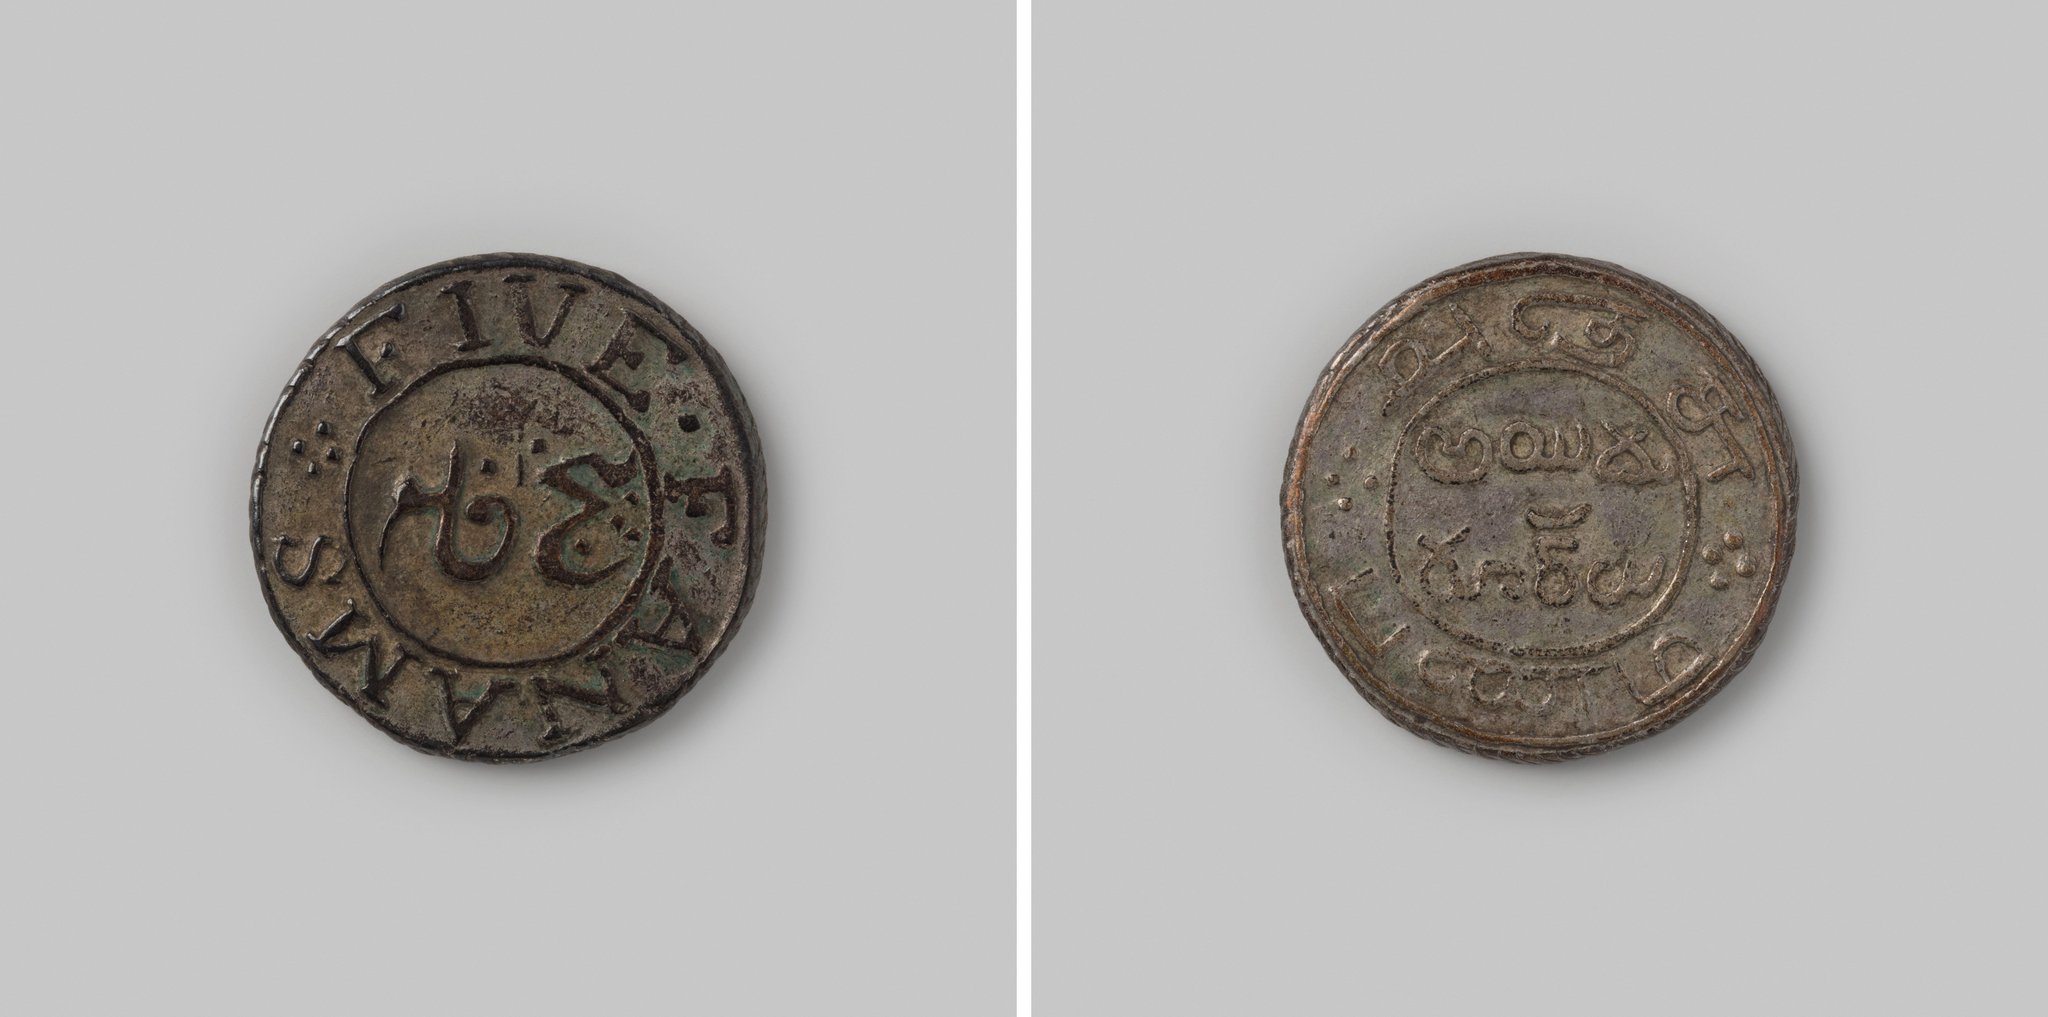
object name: coin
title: 5 fanams voor Madras in India van de Engelse Oostindische Compagnie (EIC), (1807)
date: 1807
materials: silver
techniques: striking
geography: chennai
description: Zilveren munt. Voorzijde: binnen brede rand, waarop waarde-aanduiding in het Engels: five fanams, op een regel waarde-aanduiding in Arabische lettertekens. Keerzijde: binnen brede rand, waarop waarde-aanduiding in het Tamil, in twee regels waarde- aanduiding in het Telugu. Kabelrand.